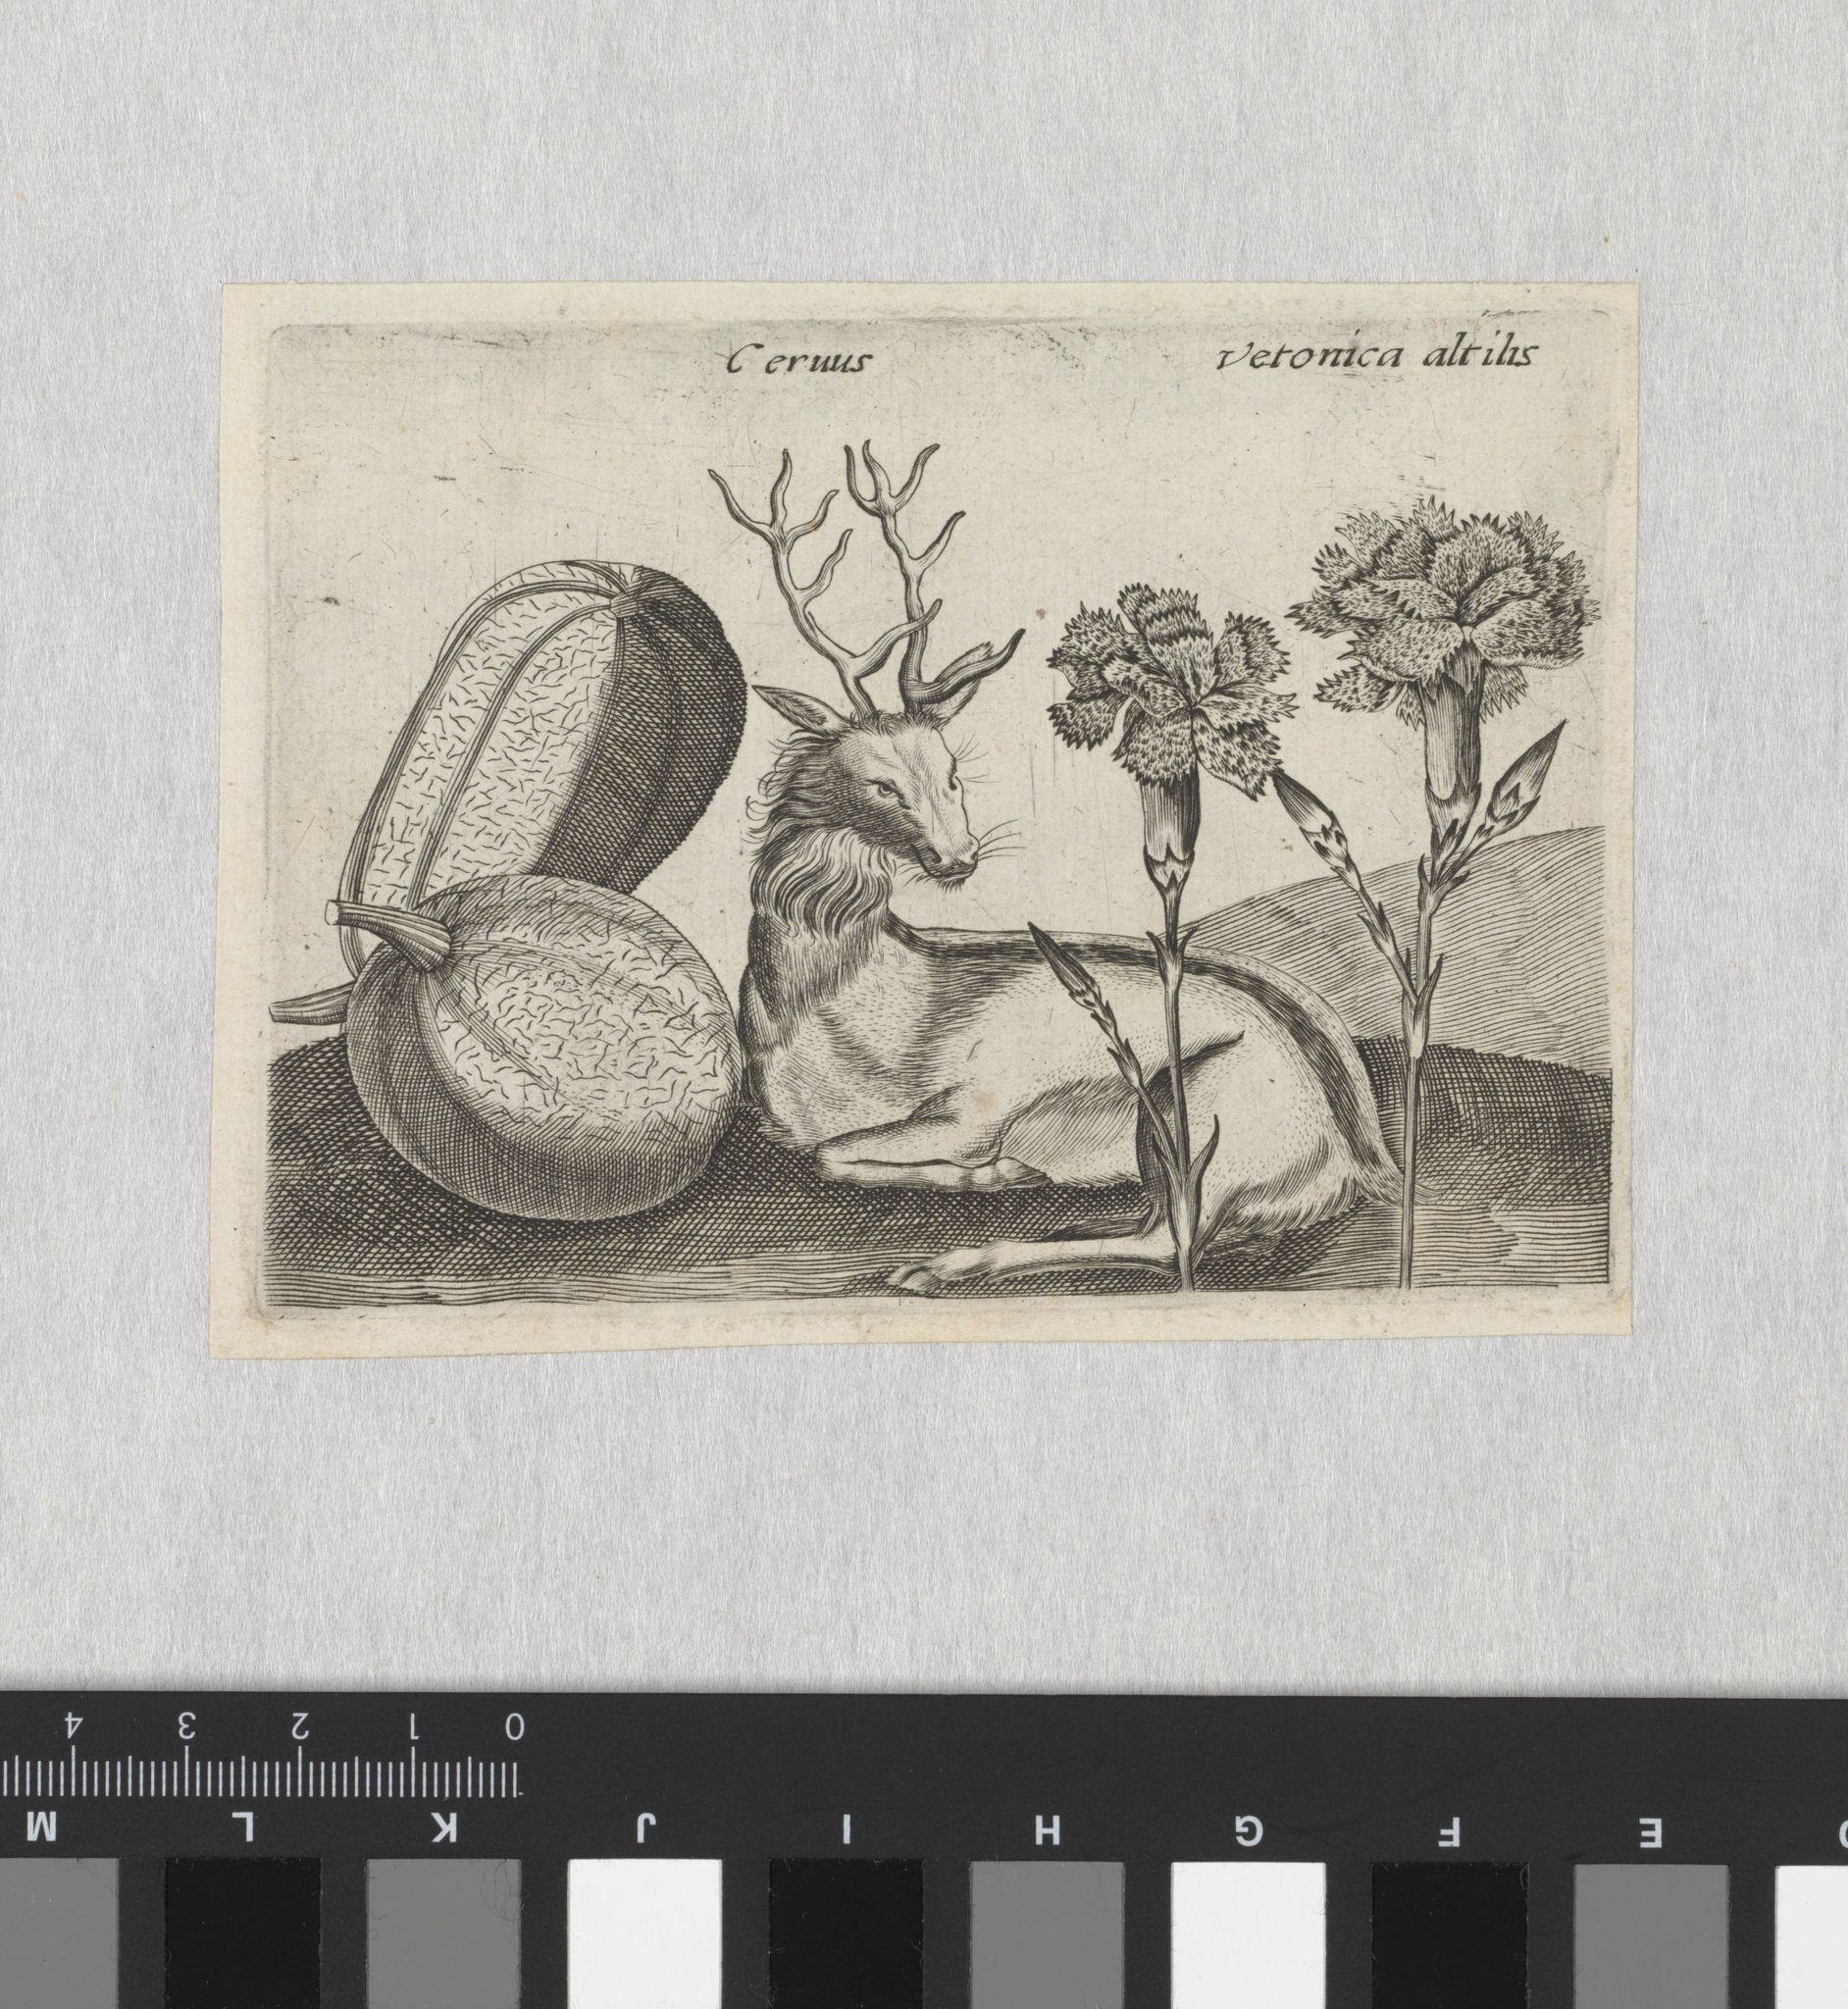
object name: print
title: Series of Prints with Flowers and Animals in a Landscape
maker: johann hogenberg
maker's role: print maker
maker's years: 1550-1618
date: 1600-1605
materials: paper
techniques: engraving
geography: germany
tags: flowers, hoofed animals, fruits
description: In making his representations of flowers and animals Hogenberg borrowed freely from prints by other artists. Some combinations are endearing, others slightly bizarre. What does a polar bear have to do with artichokes? It is precisely the series’ mixture of originality and naiveté that is so appealing to modern eyes.